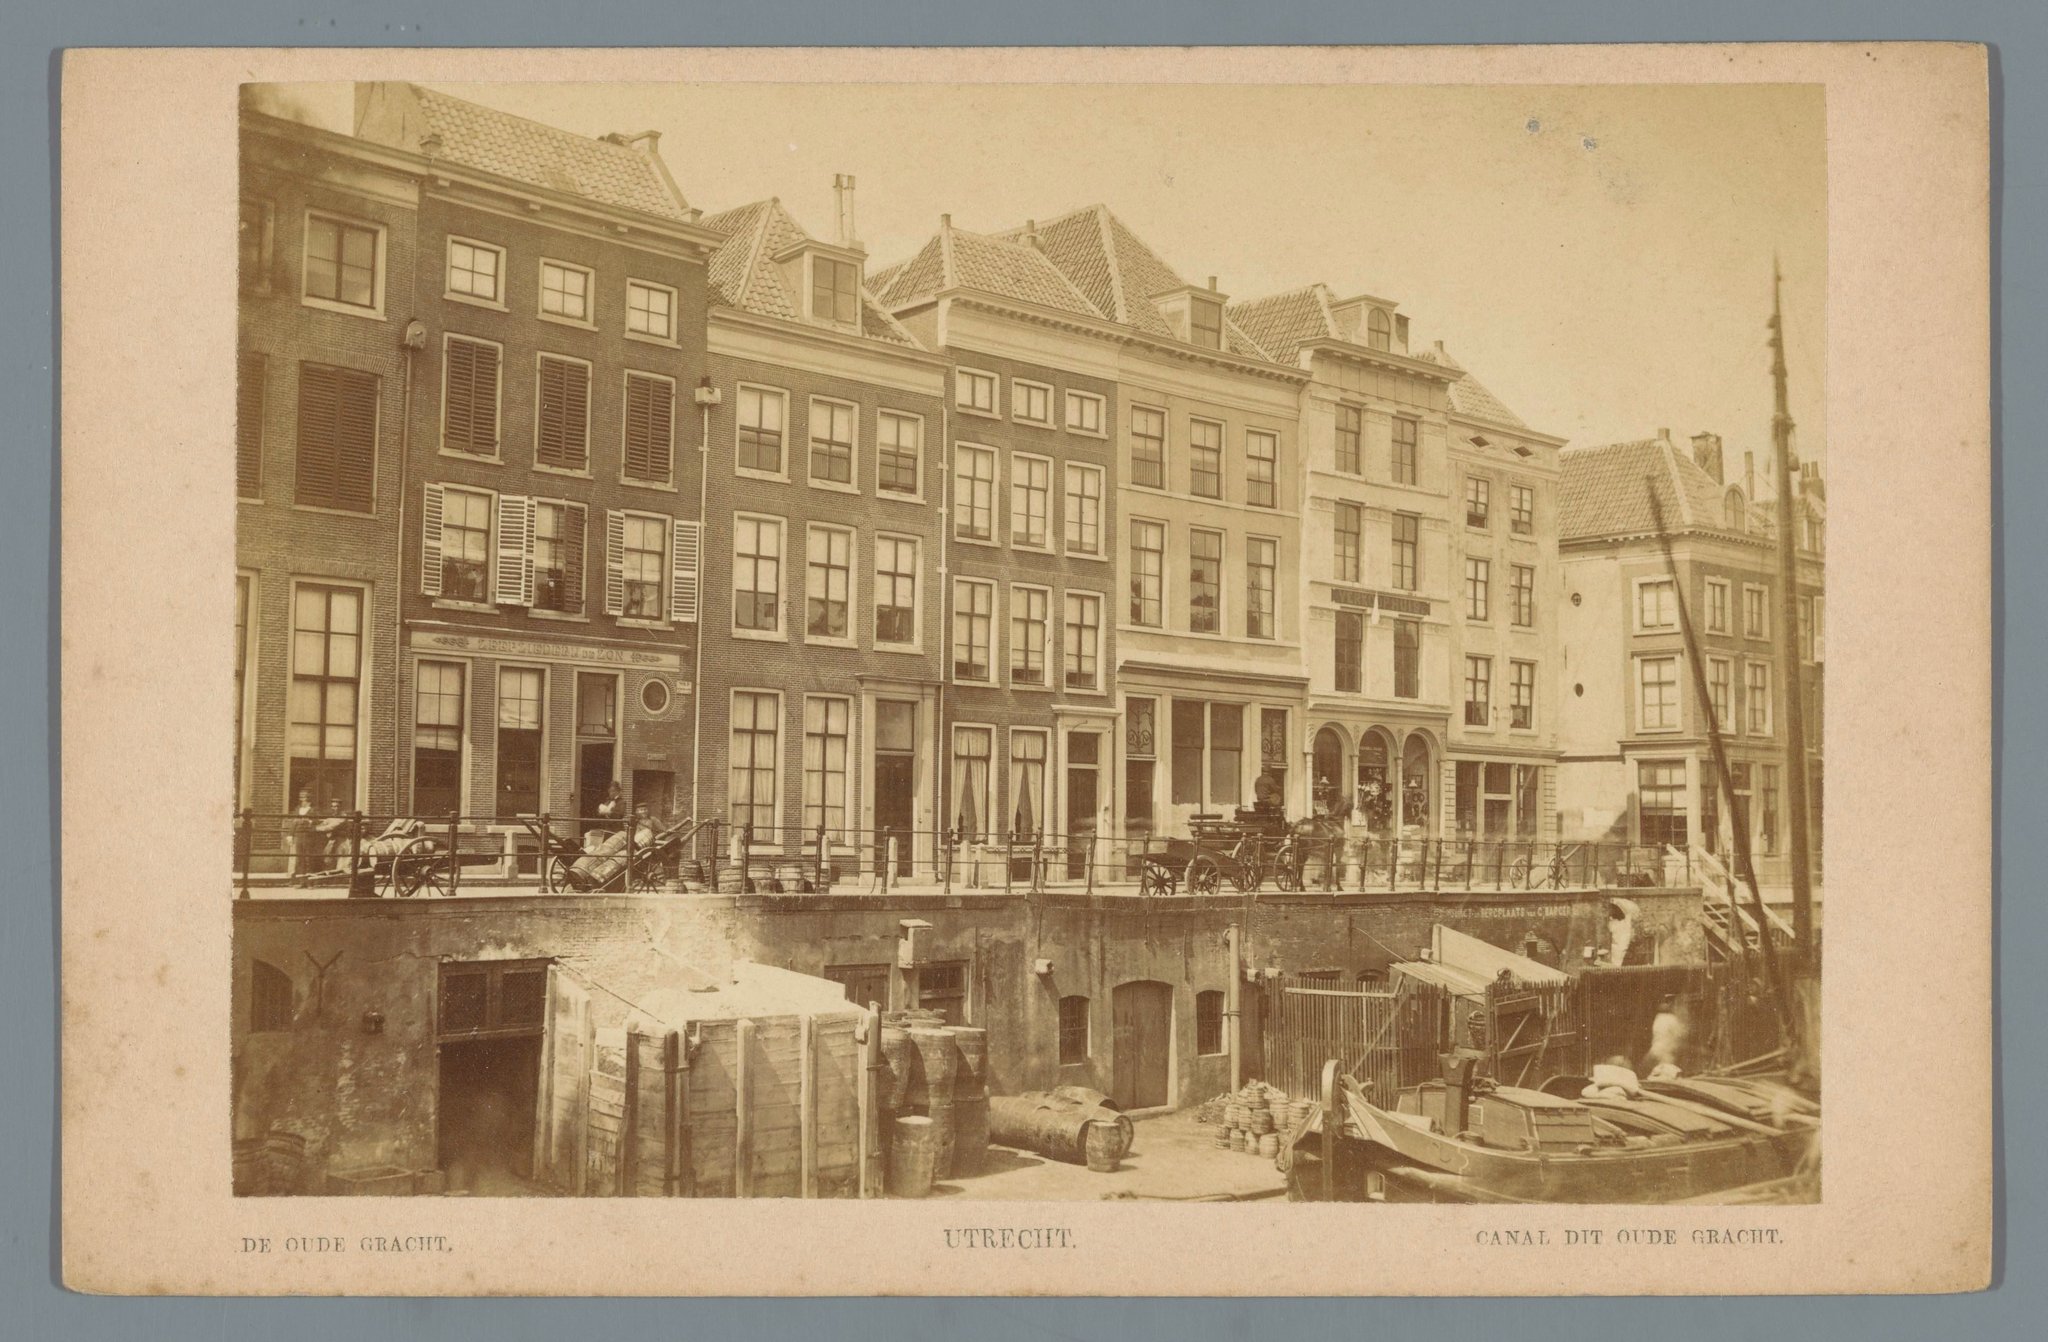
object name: cabinet photograph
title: Gezicht op de Oudegracht te Utrecht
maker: Anonymous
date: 1850-1900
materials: cardboard, photographic support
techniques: albumen print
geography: utrecht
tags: wooden container: barrel, cask, bucket, canals, waters (in city)